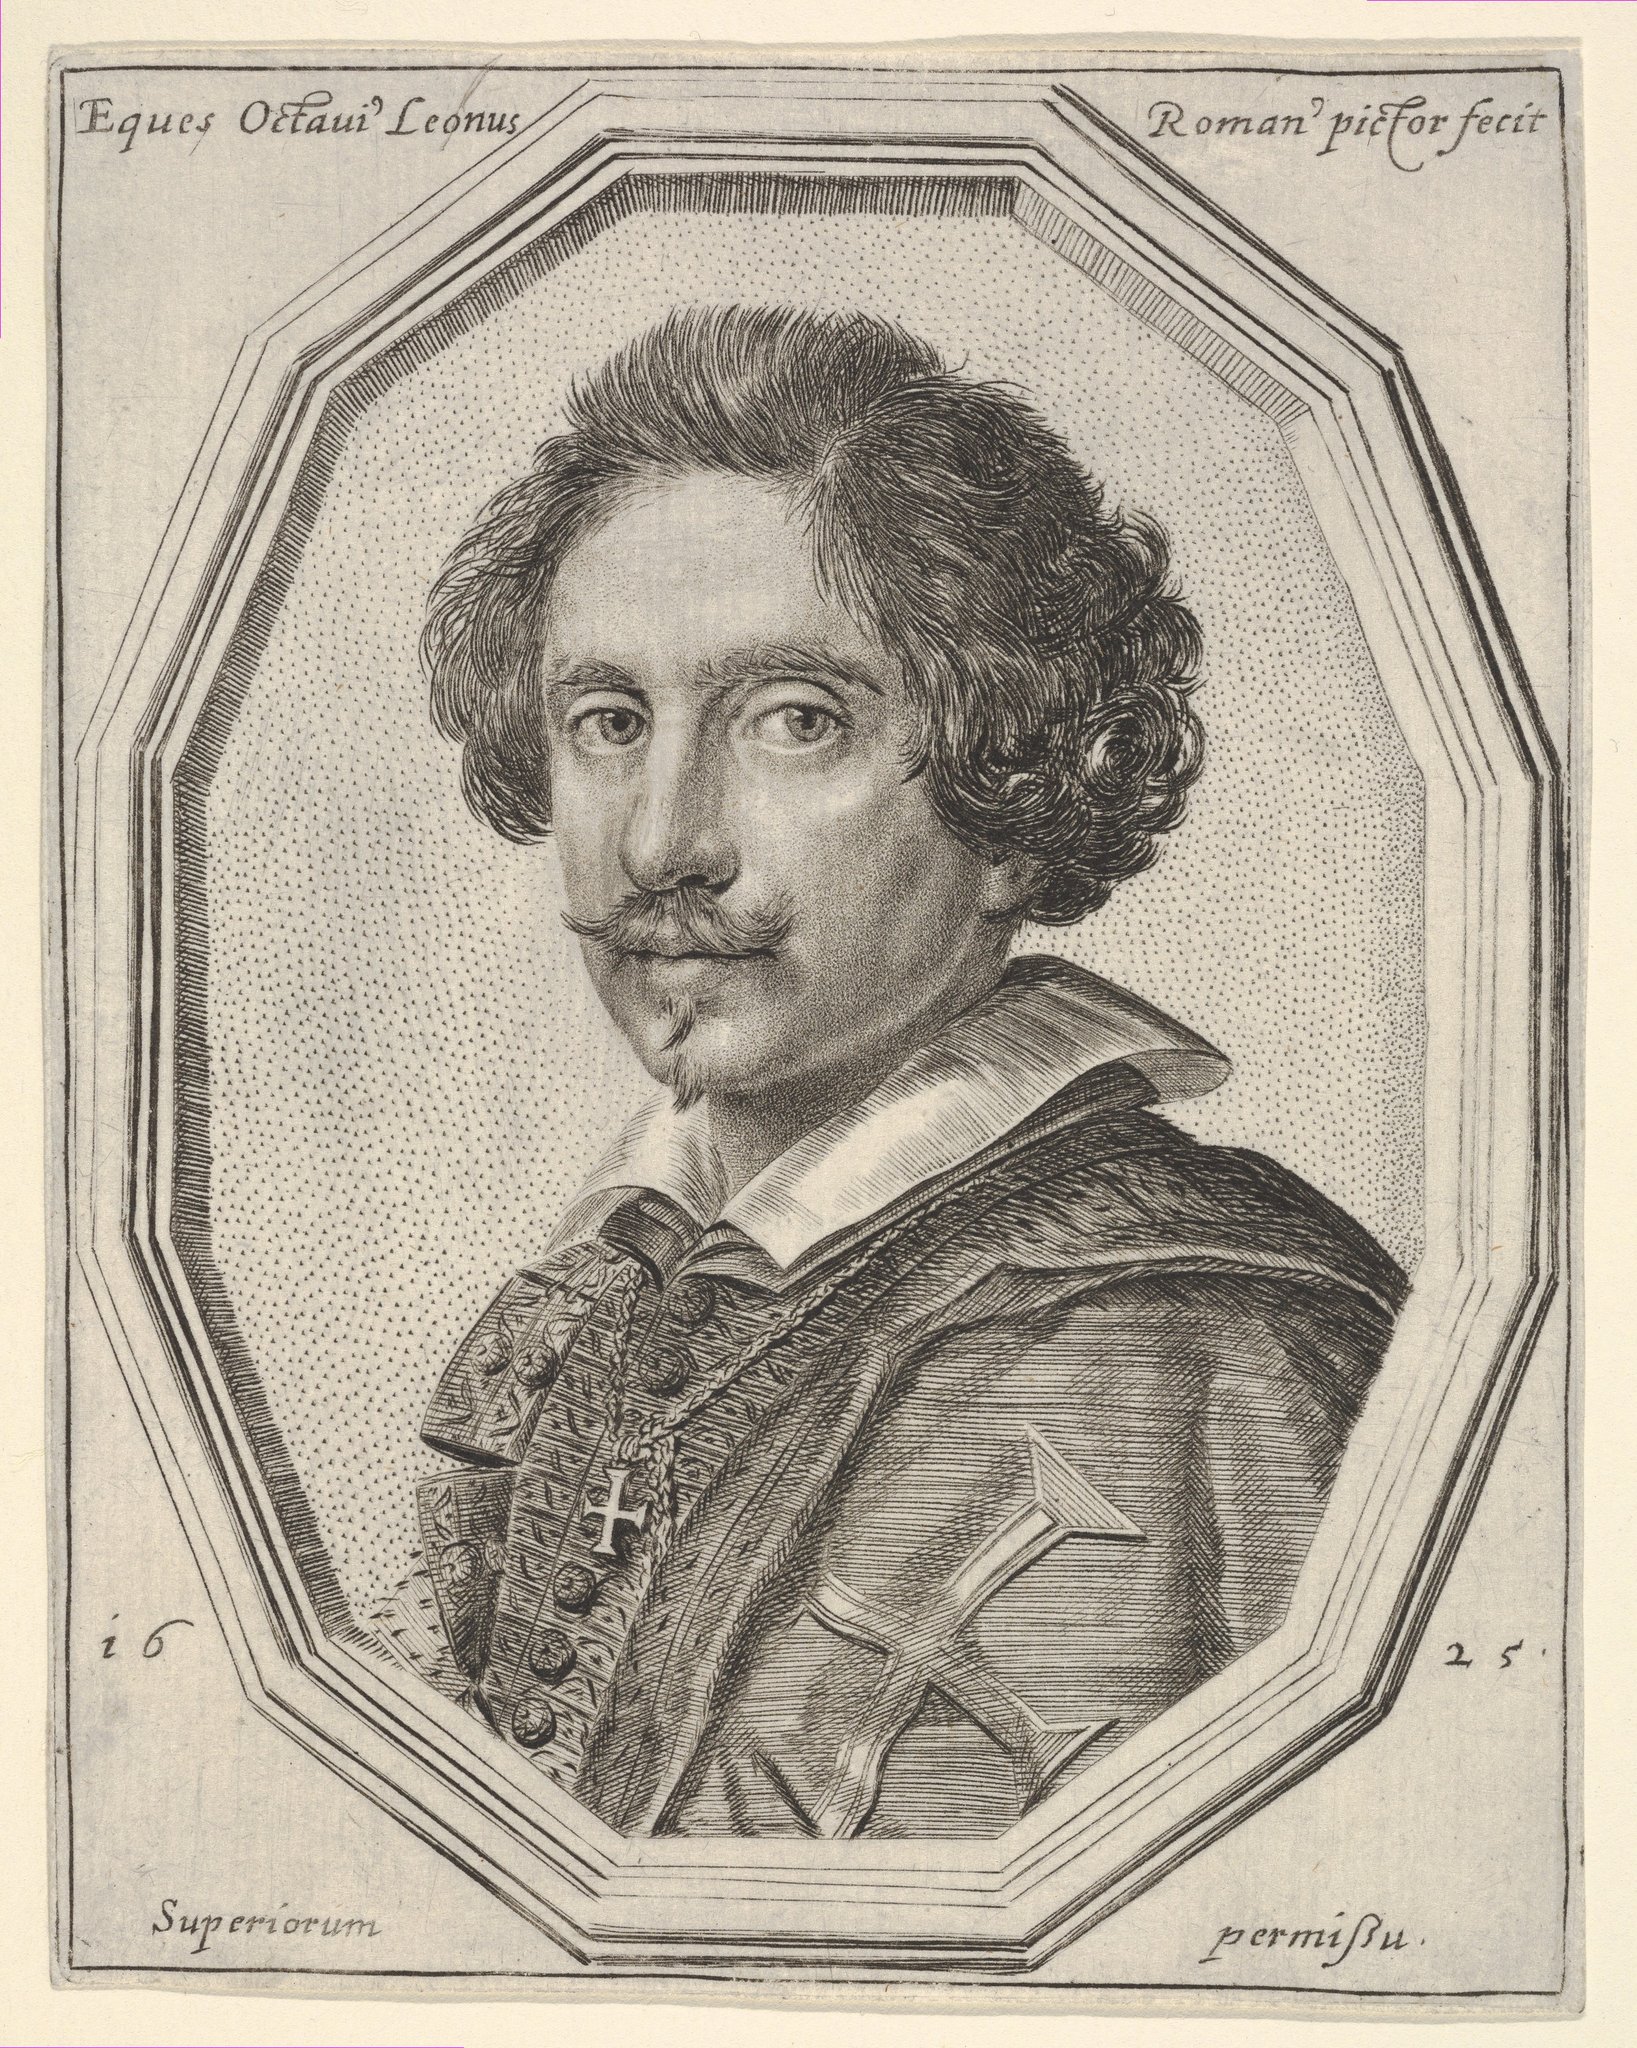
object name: print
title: Knight of Malta (self-portrait?), a bust-length portrait in a twelve-sided frame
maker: ottavio leoni (il padovano)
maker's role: artist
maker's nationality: italian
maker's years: 1578-1630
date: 1625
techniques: engraving, etching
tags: men,portraits